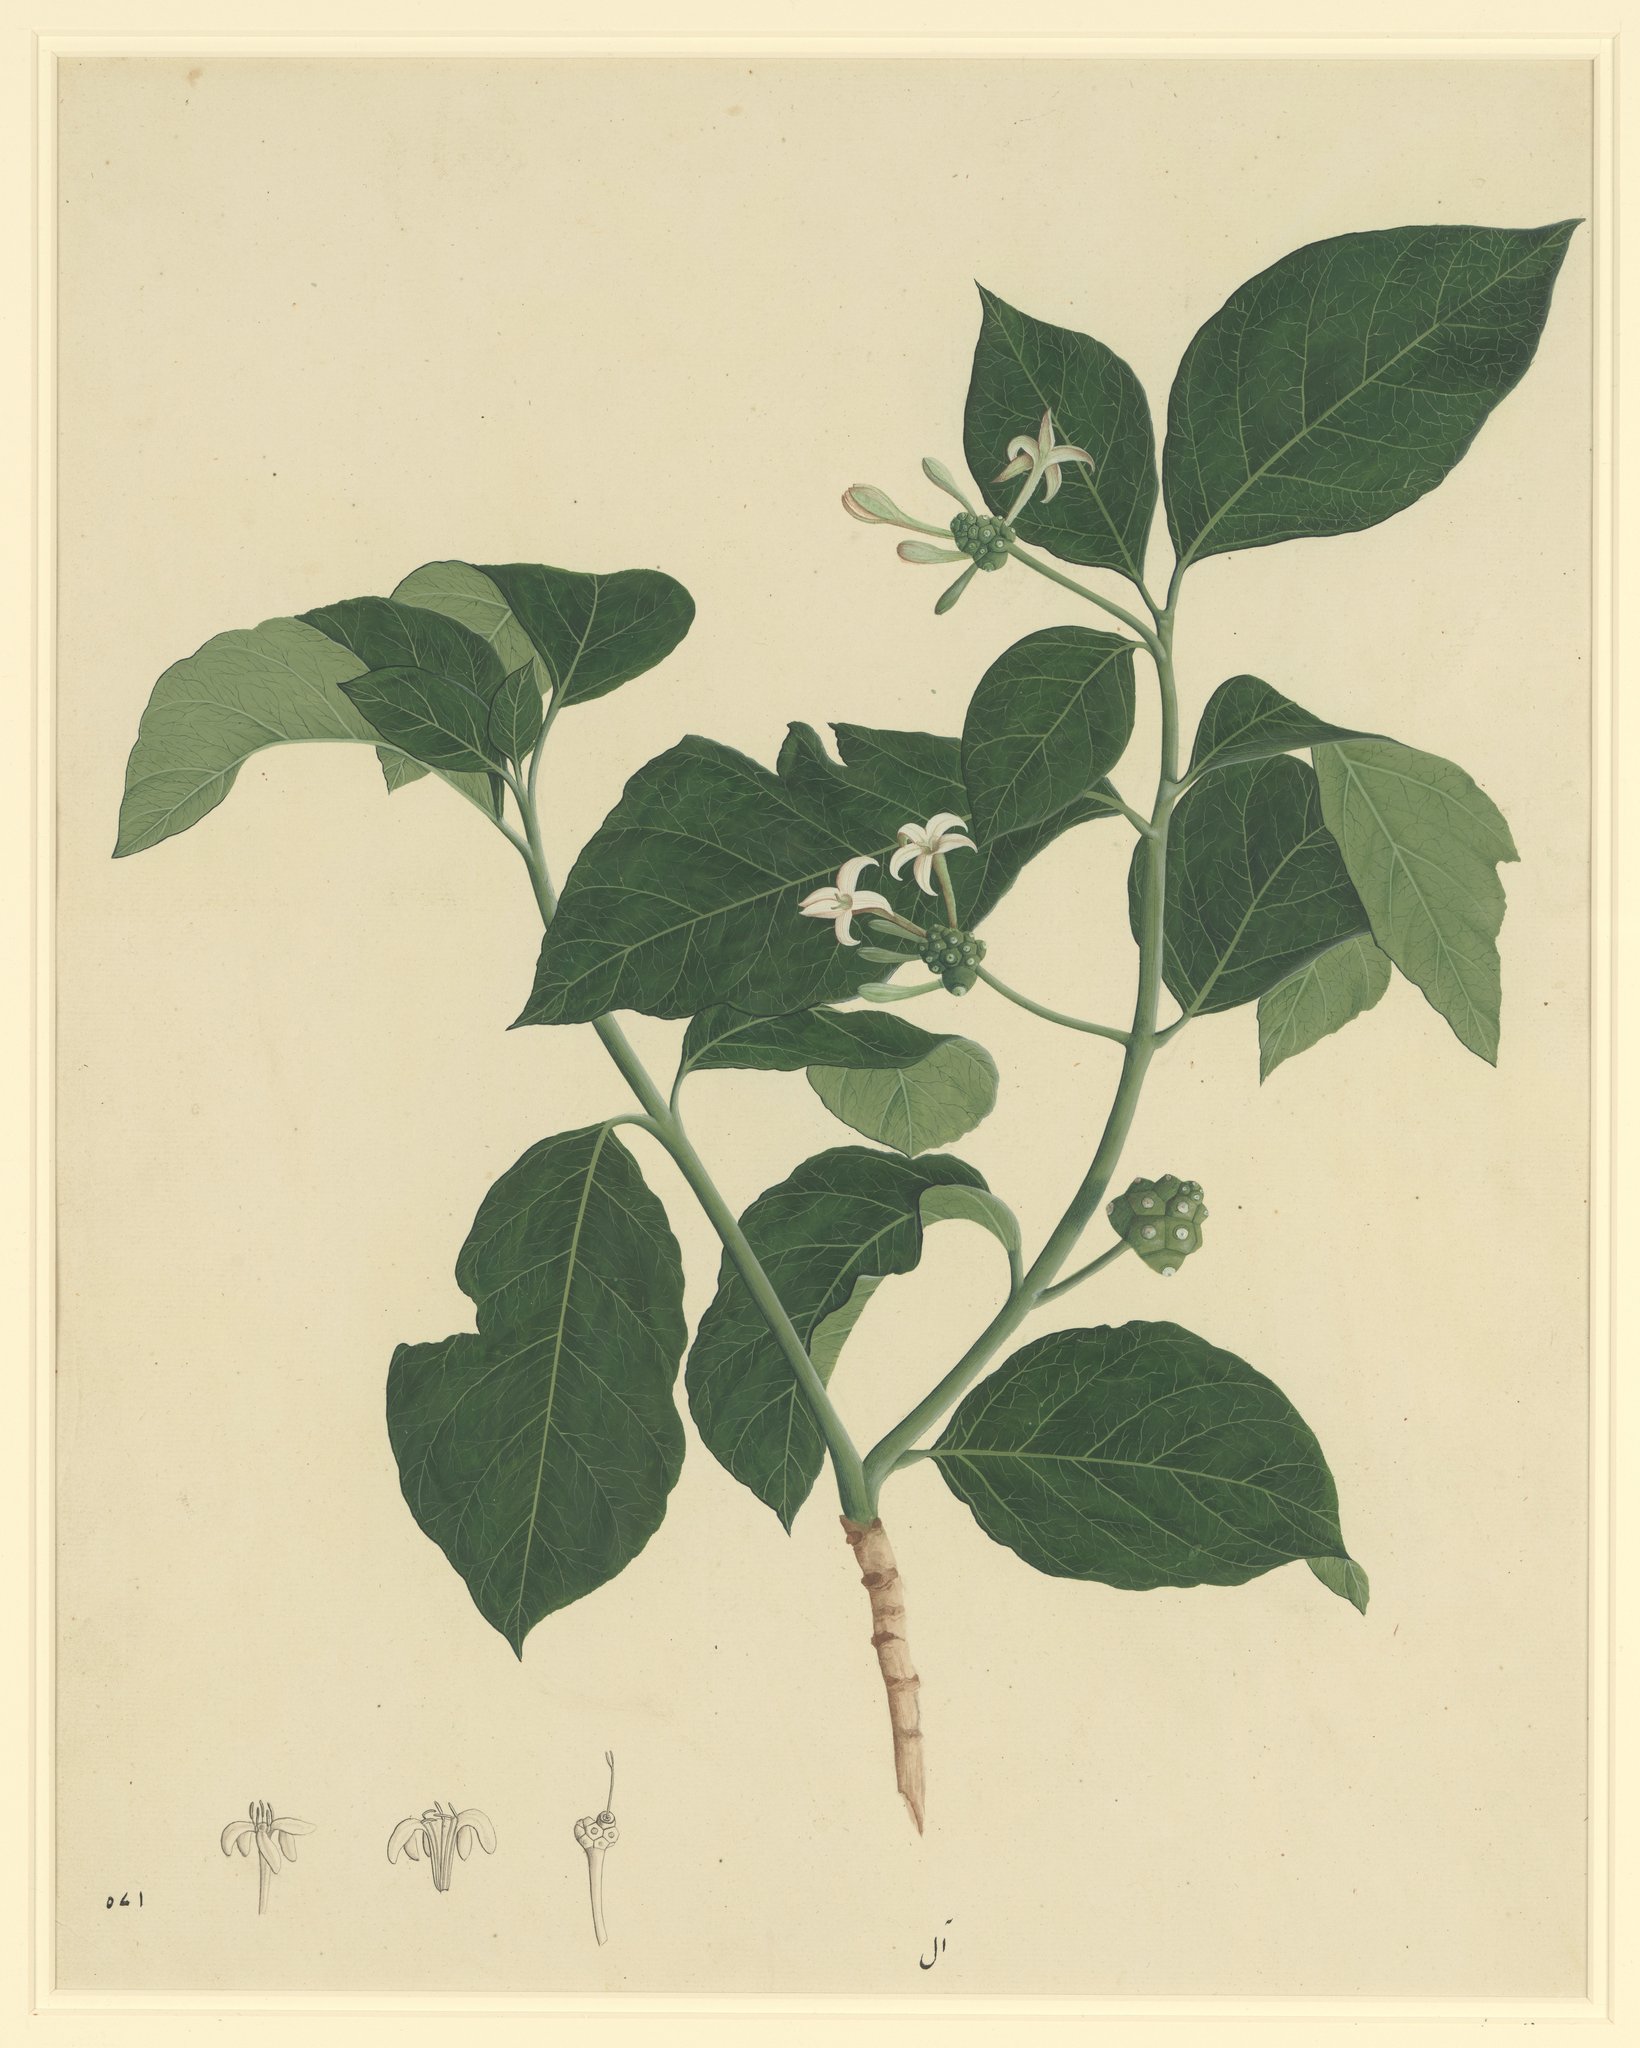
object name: illustrated single work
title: Botanical Study of Indian Mulberry (Morinda citrifolia)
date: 1767-1800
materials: paper, watercolor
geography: india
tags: flowers,leaves